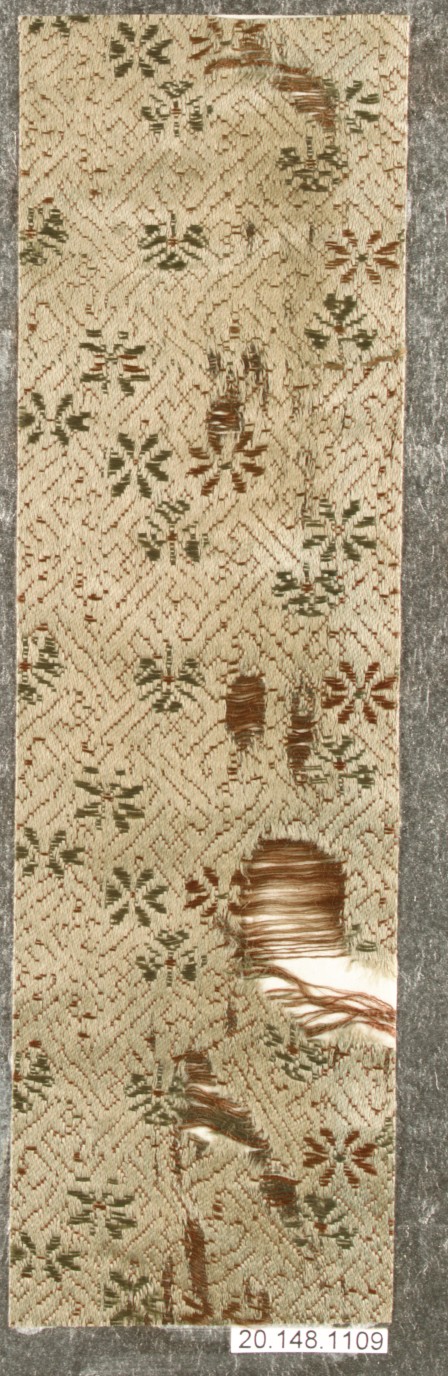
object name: piece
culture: japanese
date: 1701-1800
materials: silk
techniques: compound weave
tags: birds,flowers